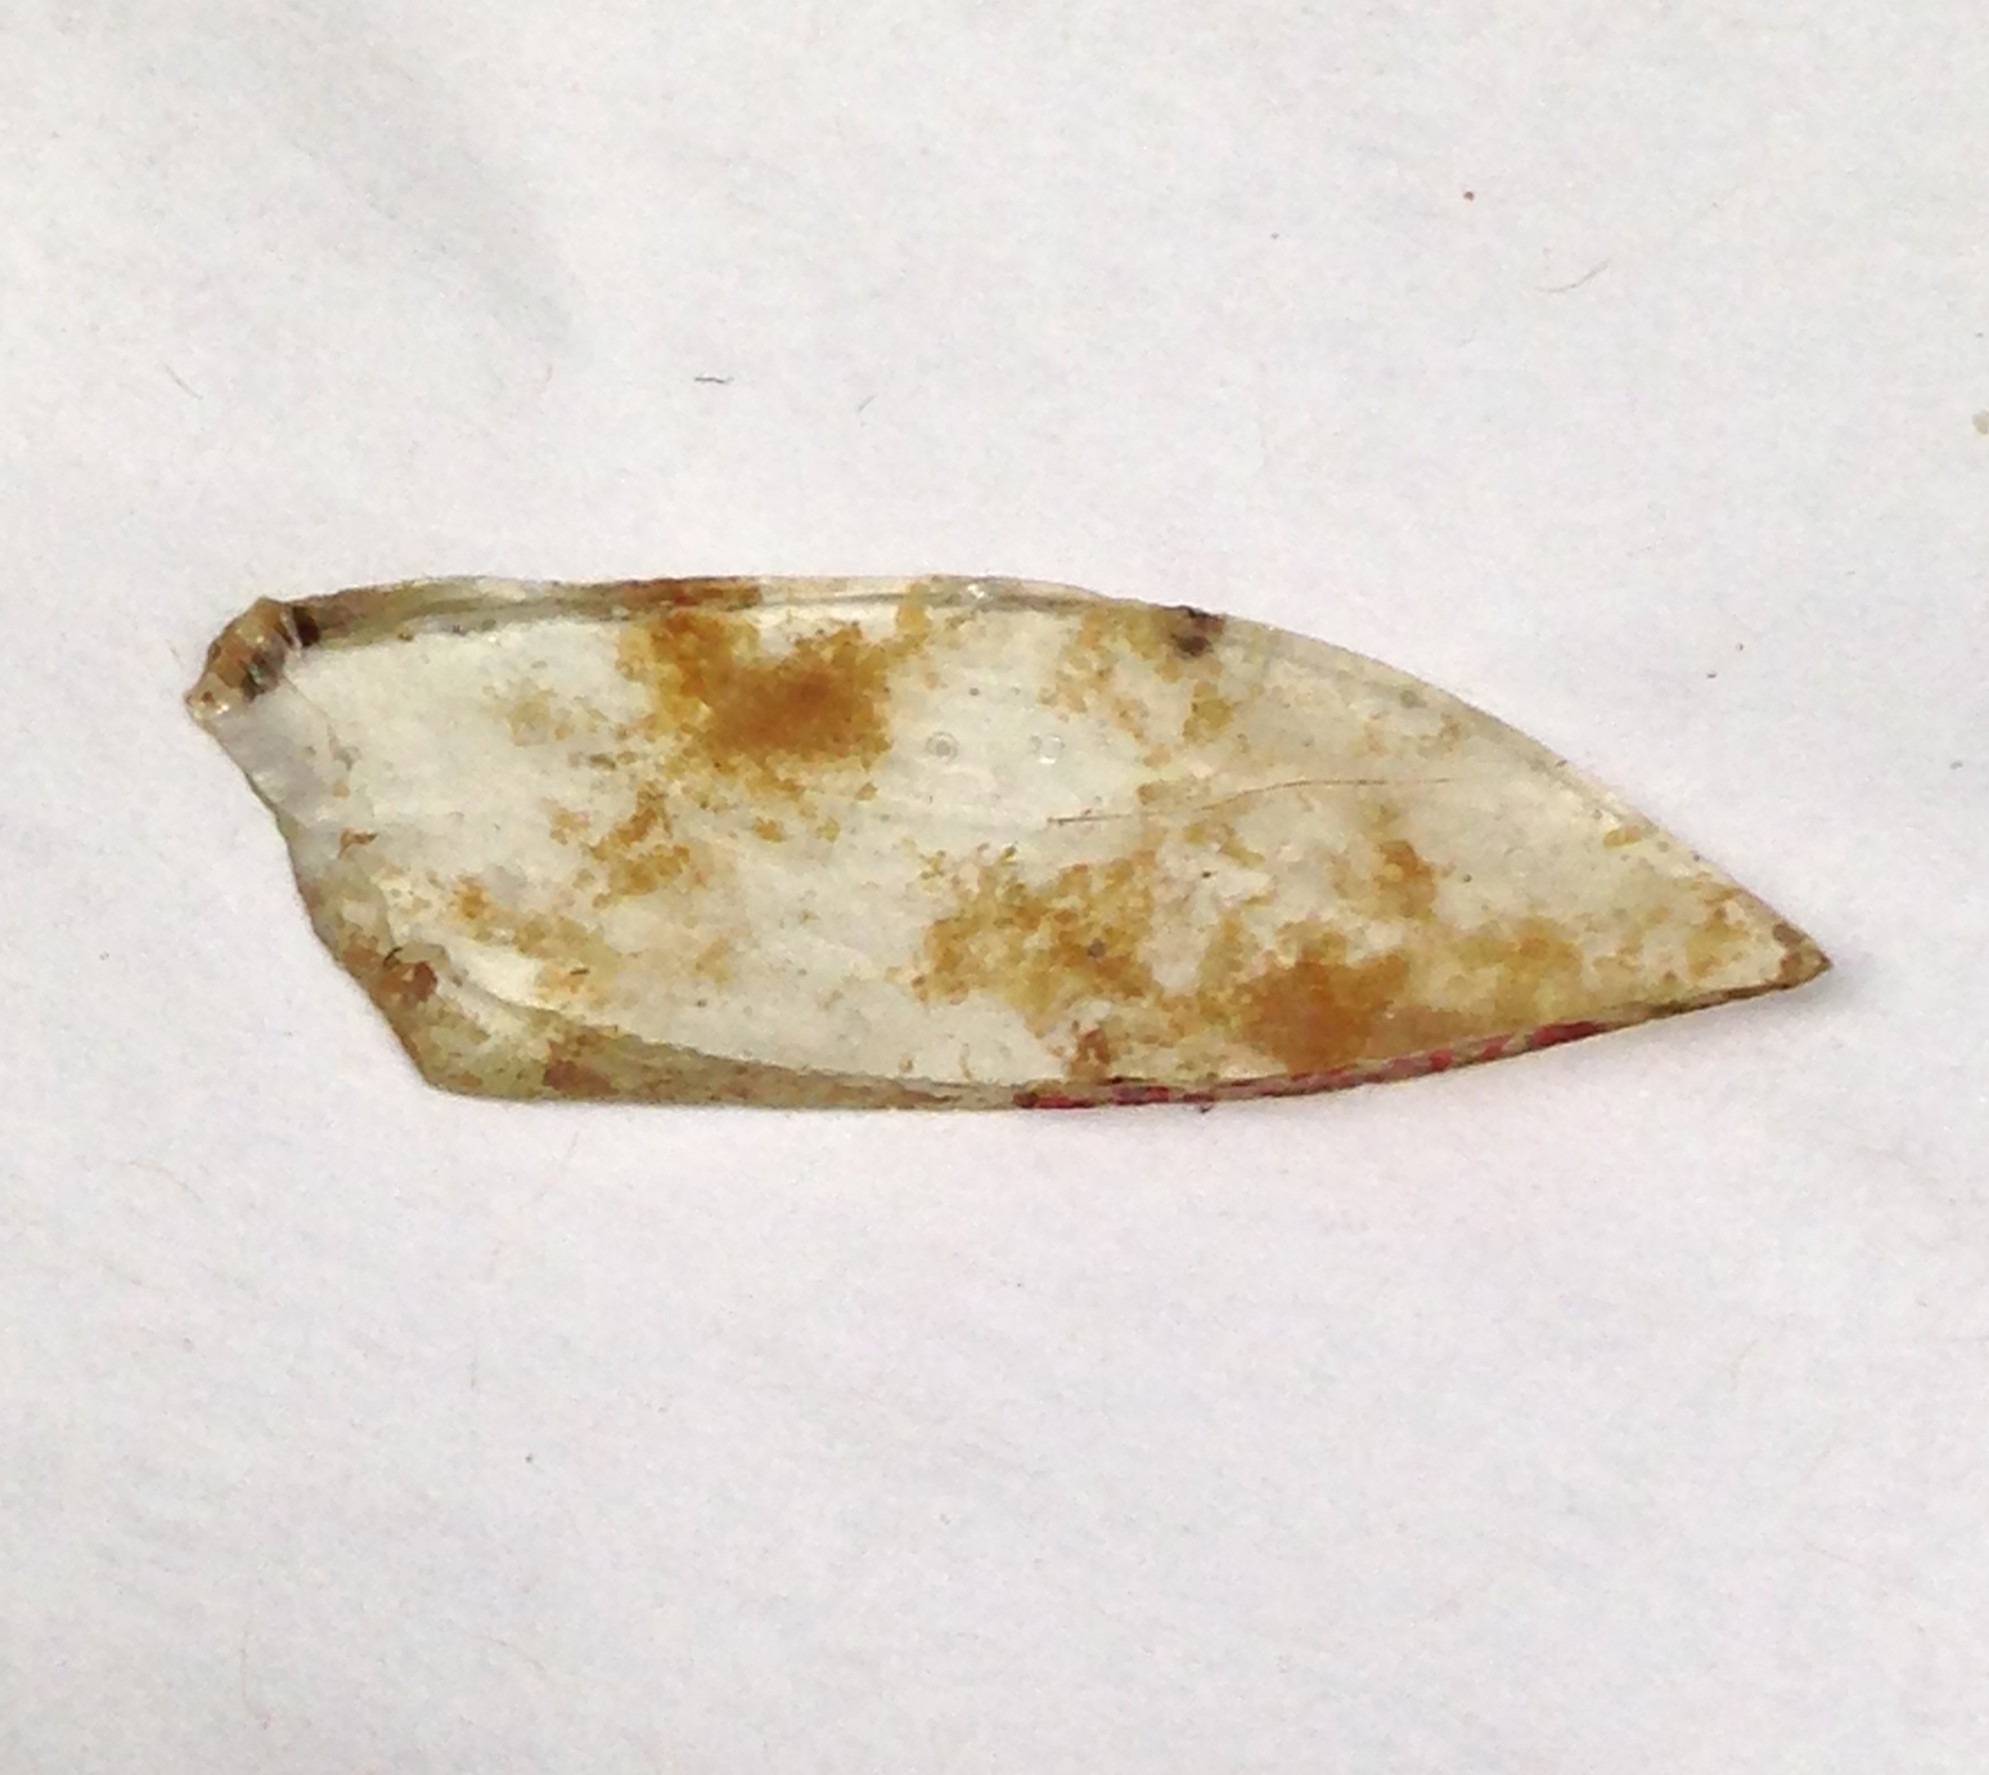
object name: fragment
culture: european or middle eastern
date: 1150-1250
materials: ceramic, glass